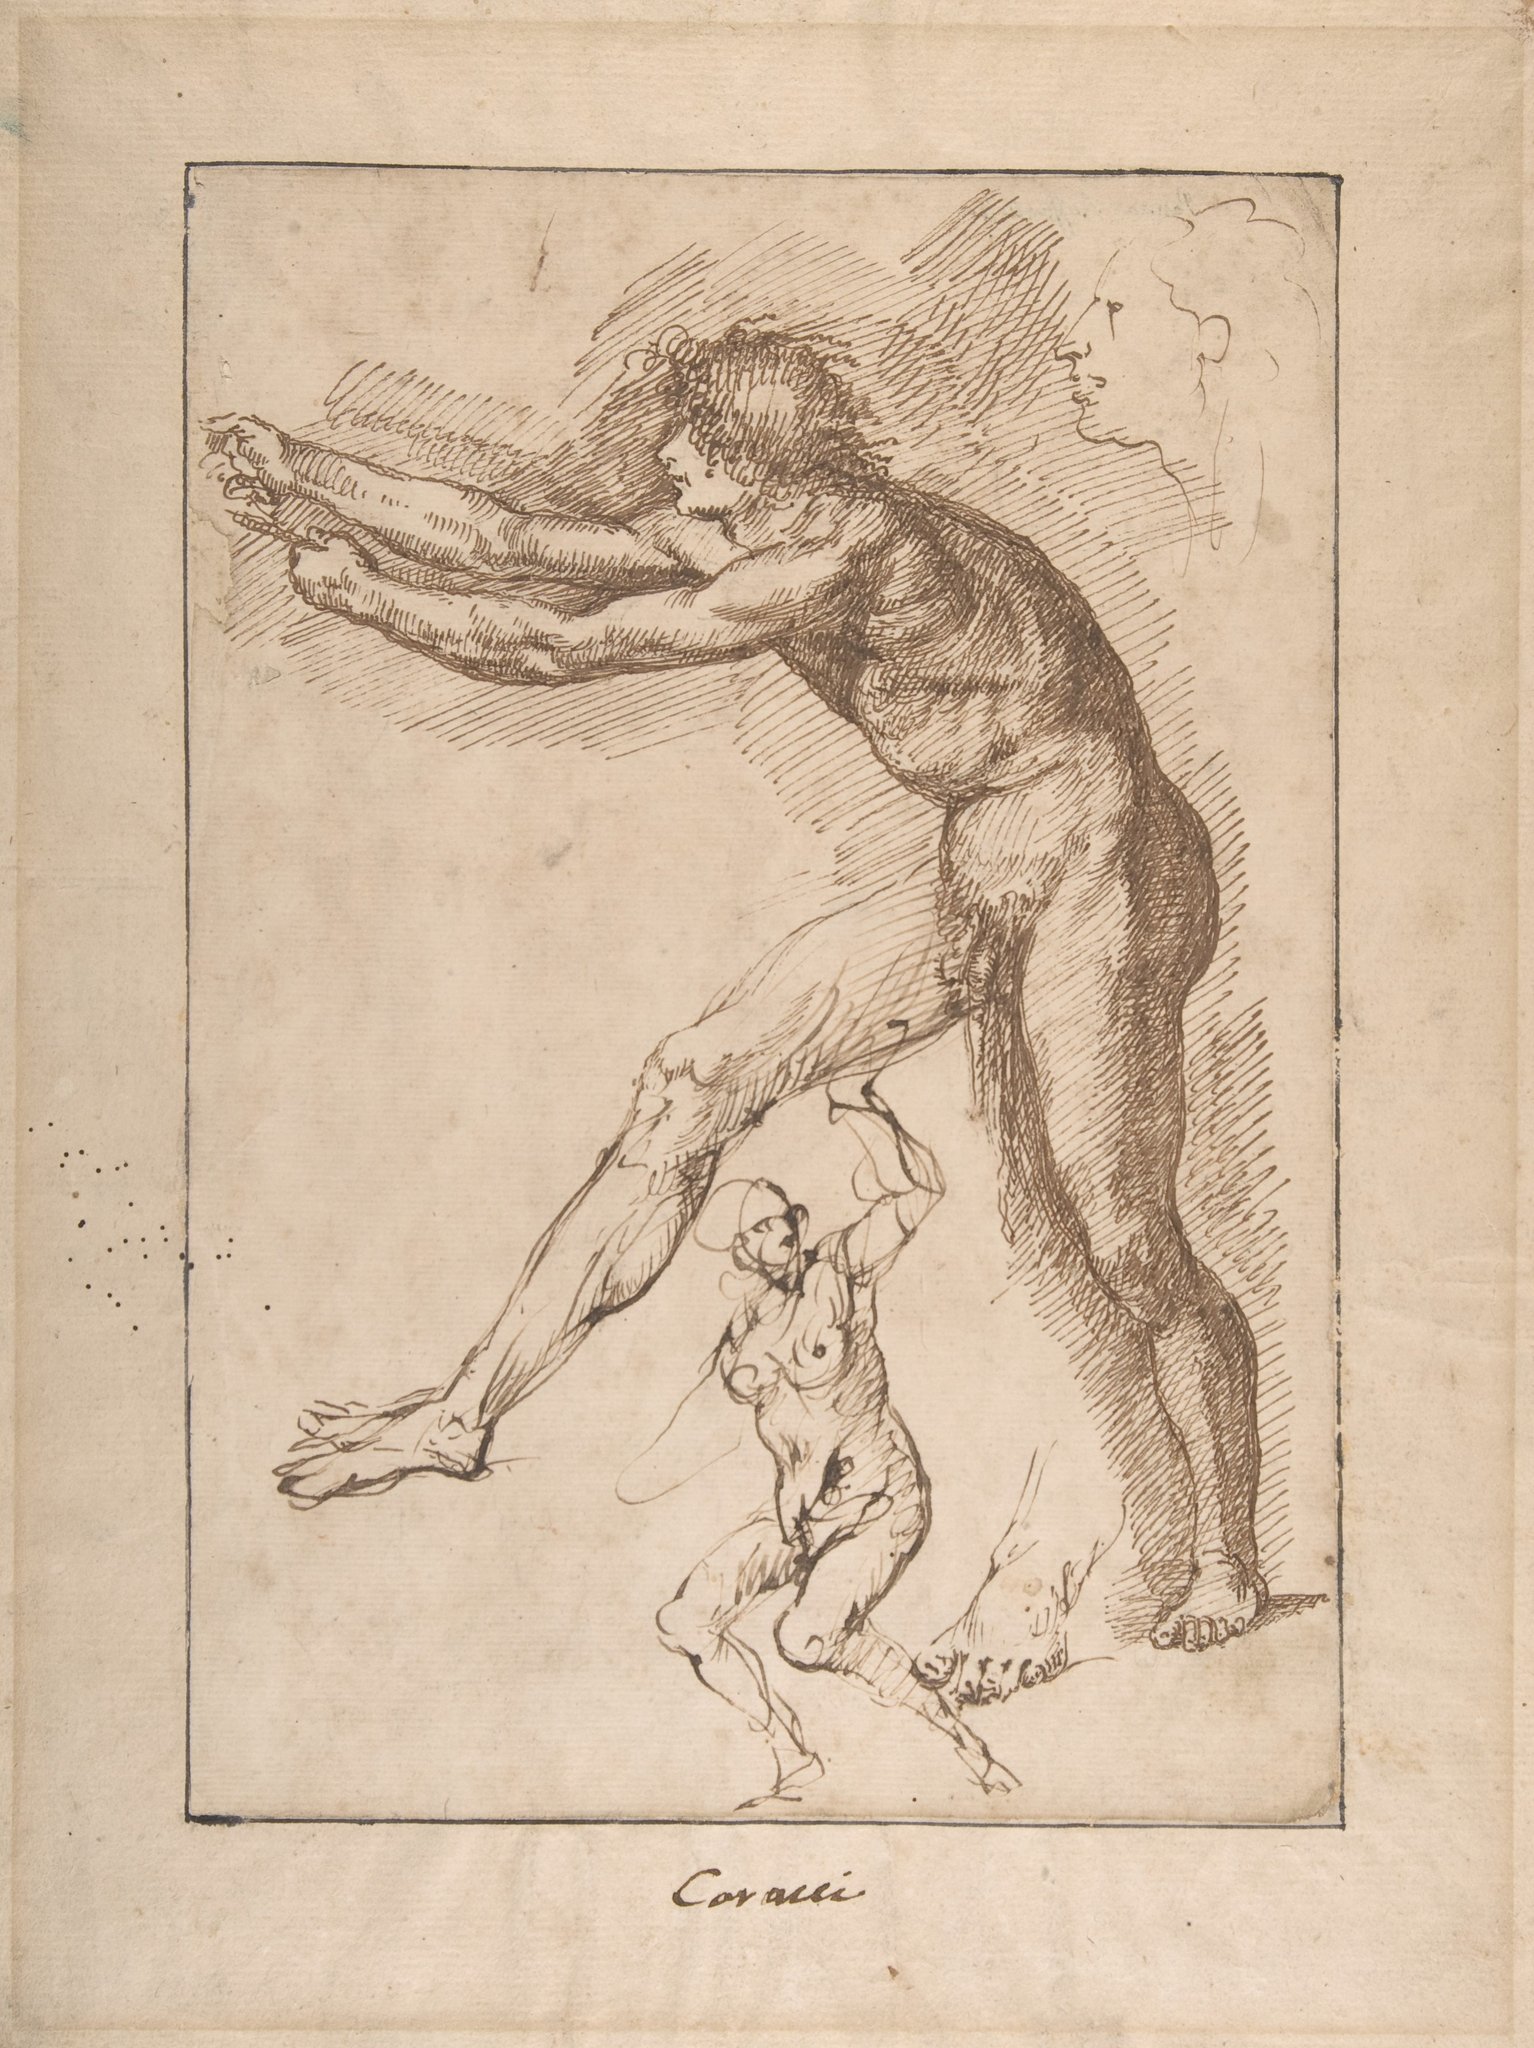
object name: drawing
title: Studies of a Nude Male Figure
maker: anonymous, italian, roman-bolognese, 17th century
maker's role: artist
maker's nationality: italian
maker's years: 1600-1700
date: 1601-1700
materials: ink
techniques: pen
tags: male nudes